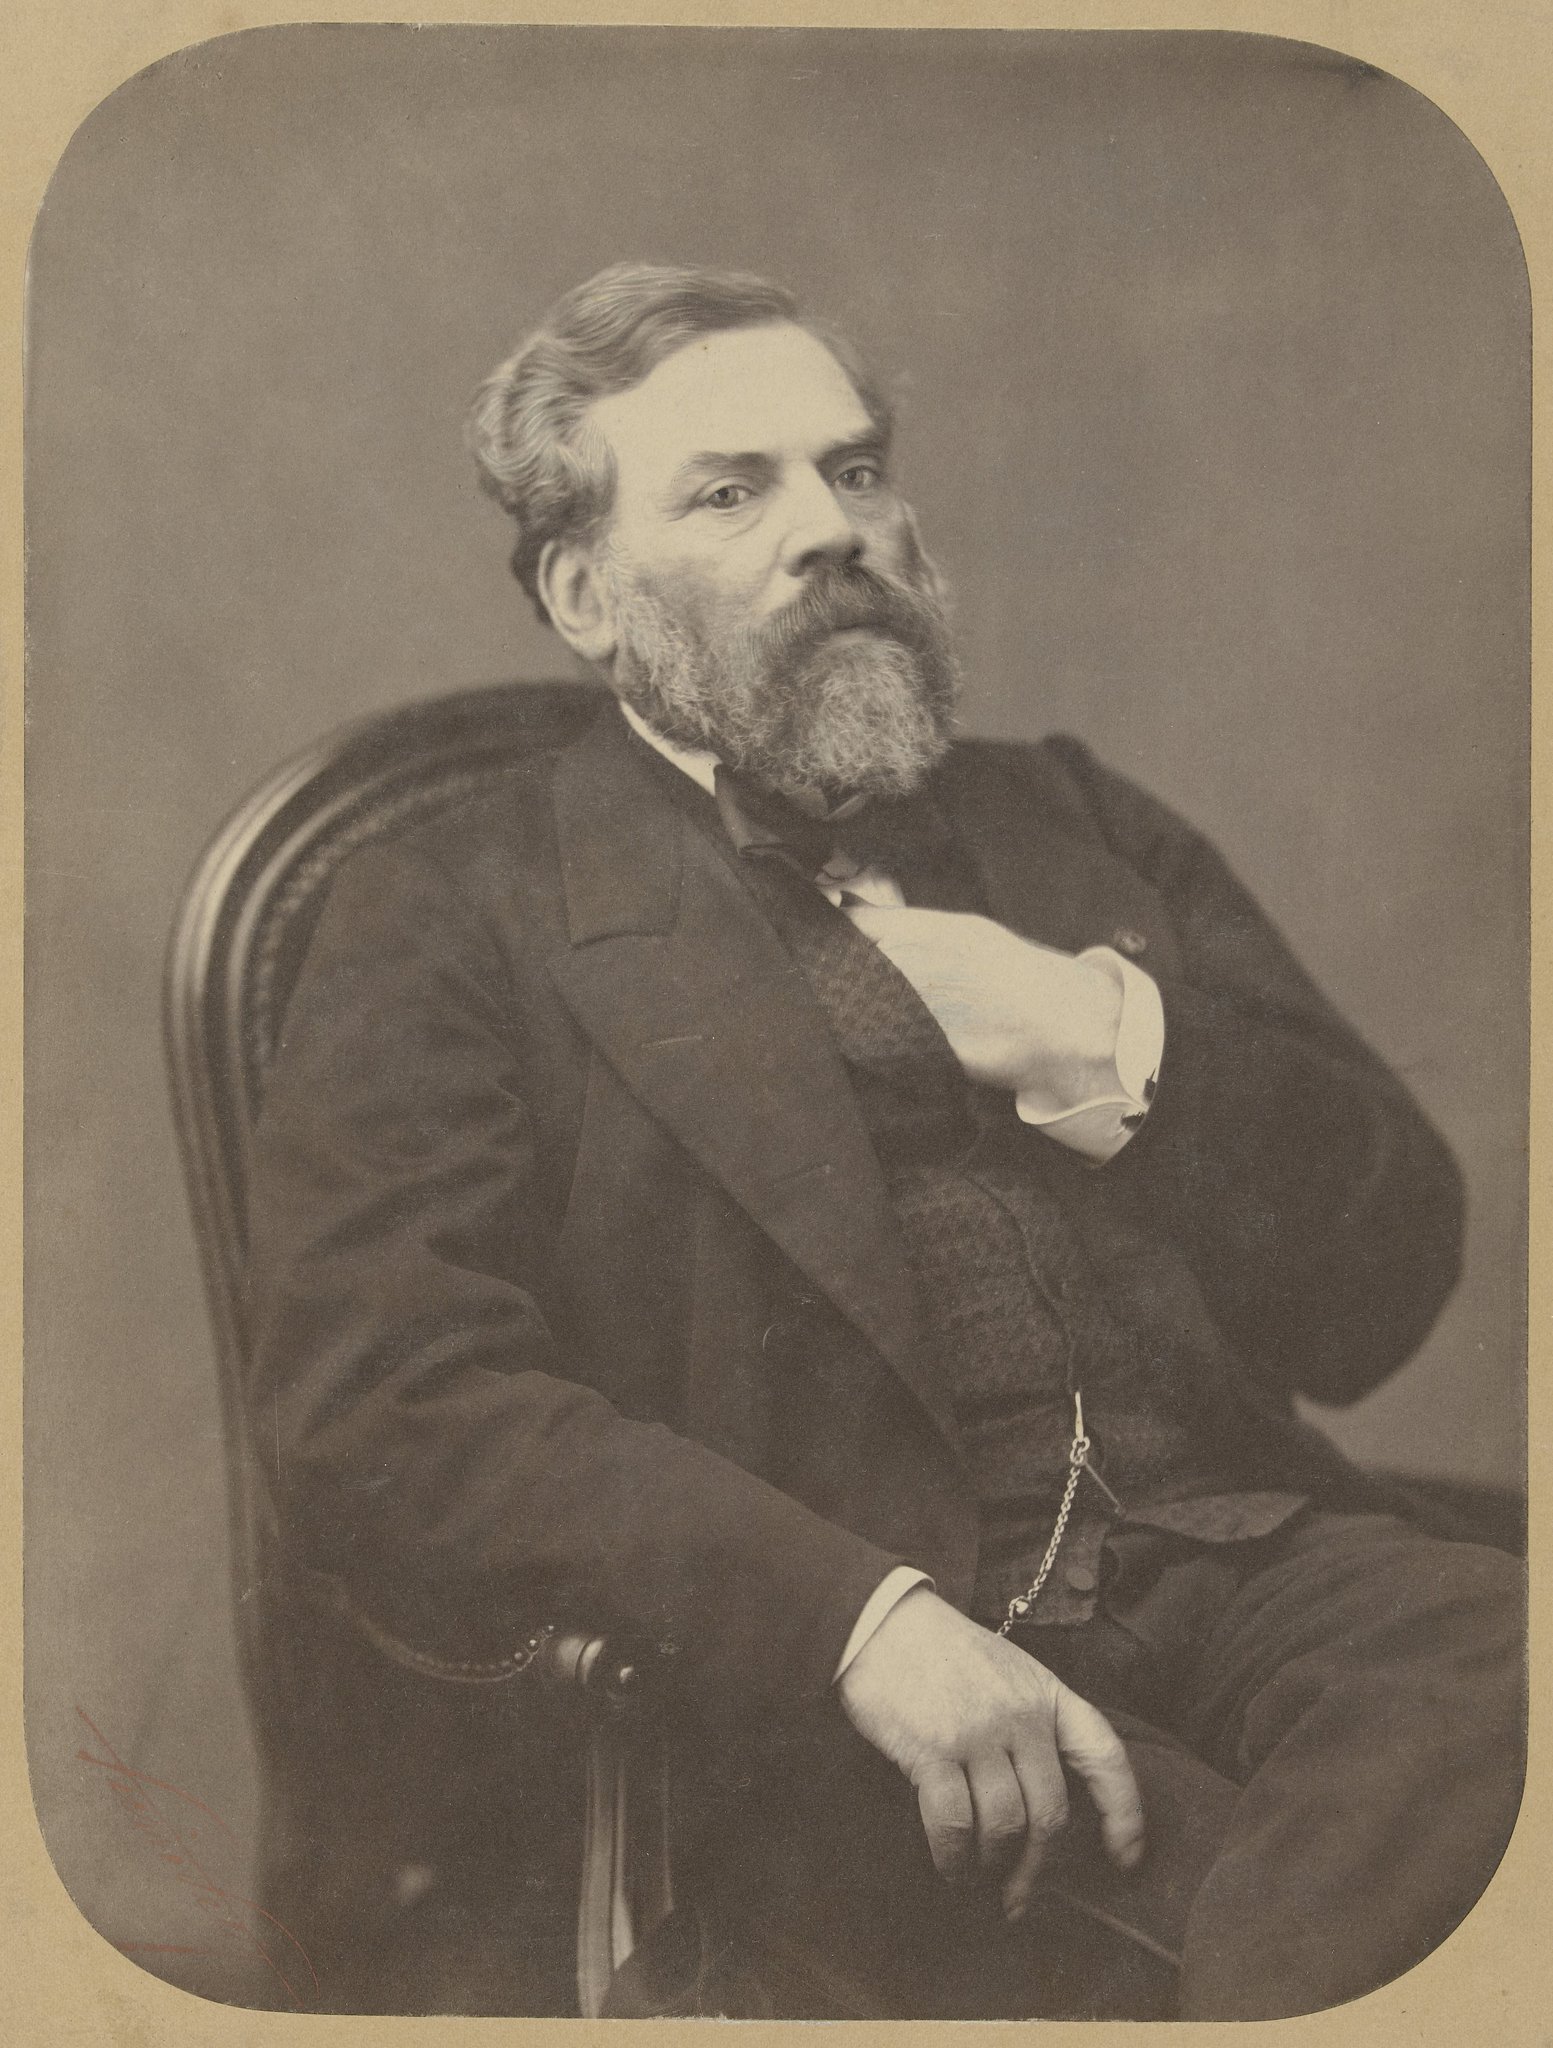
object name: photograph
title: Portret van een onbekende man met baard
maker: pierre petit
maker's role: fotograaf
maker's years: 1832-1909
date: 1855-1865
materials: cardboard, paper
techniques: albumen print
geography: paris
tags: historical persons not known by name, paris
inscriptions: signature: ‘Pierre Petit’